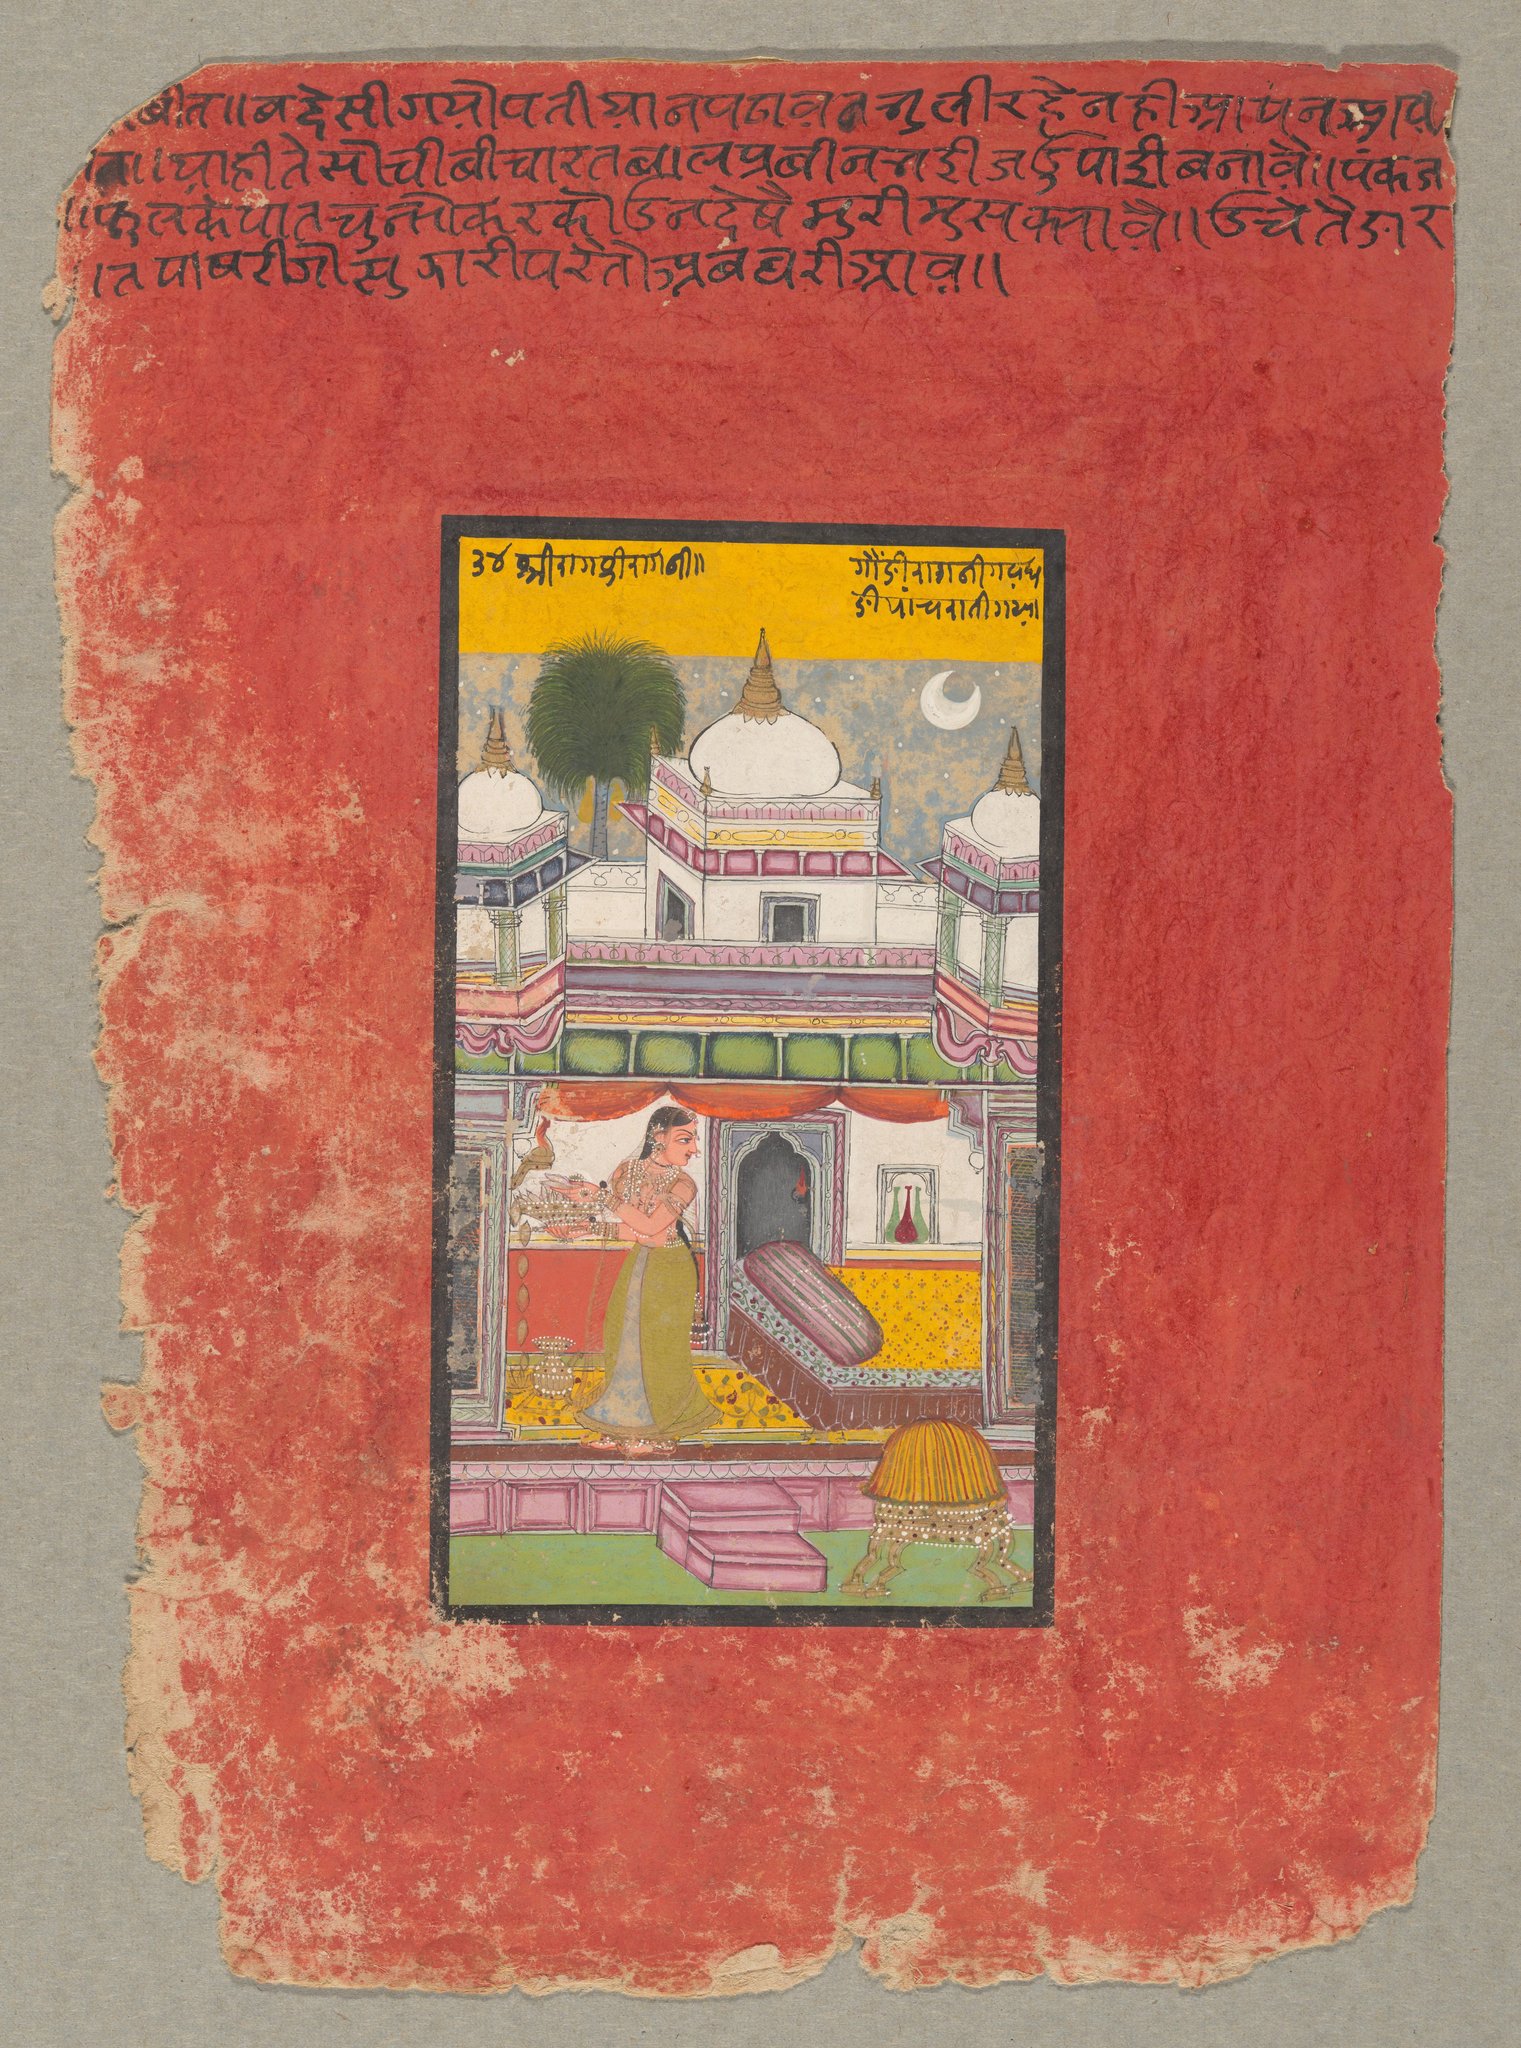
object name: drawing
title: Ragamala painting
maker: Anonymous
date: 1690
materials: paper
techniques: brush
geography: india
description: Gunu Ragini, Bundi Purchased from Mr E. Isacco, Galerie Marco Polo, Paris 1978 (circa